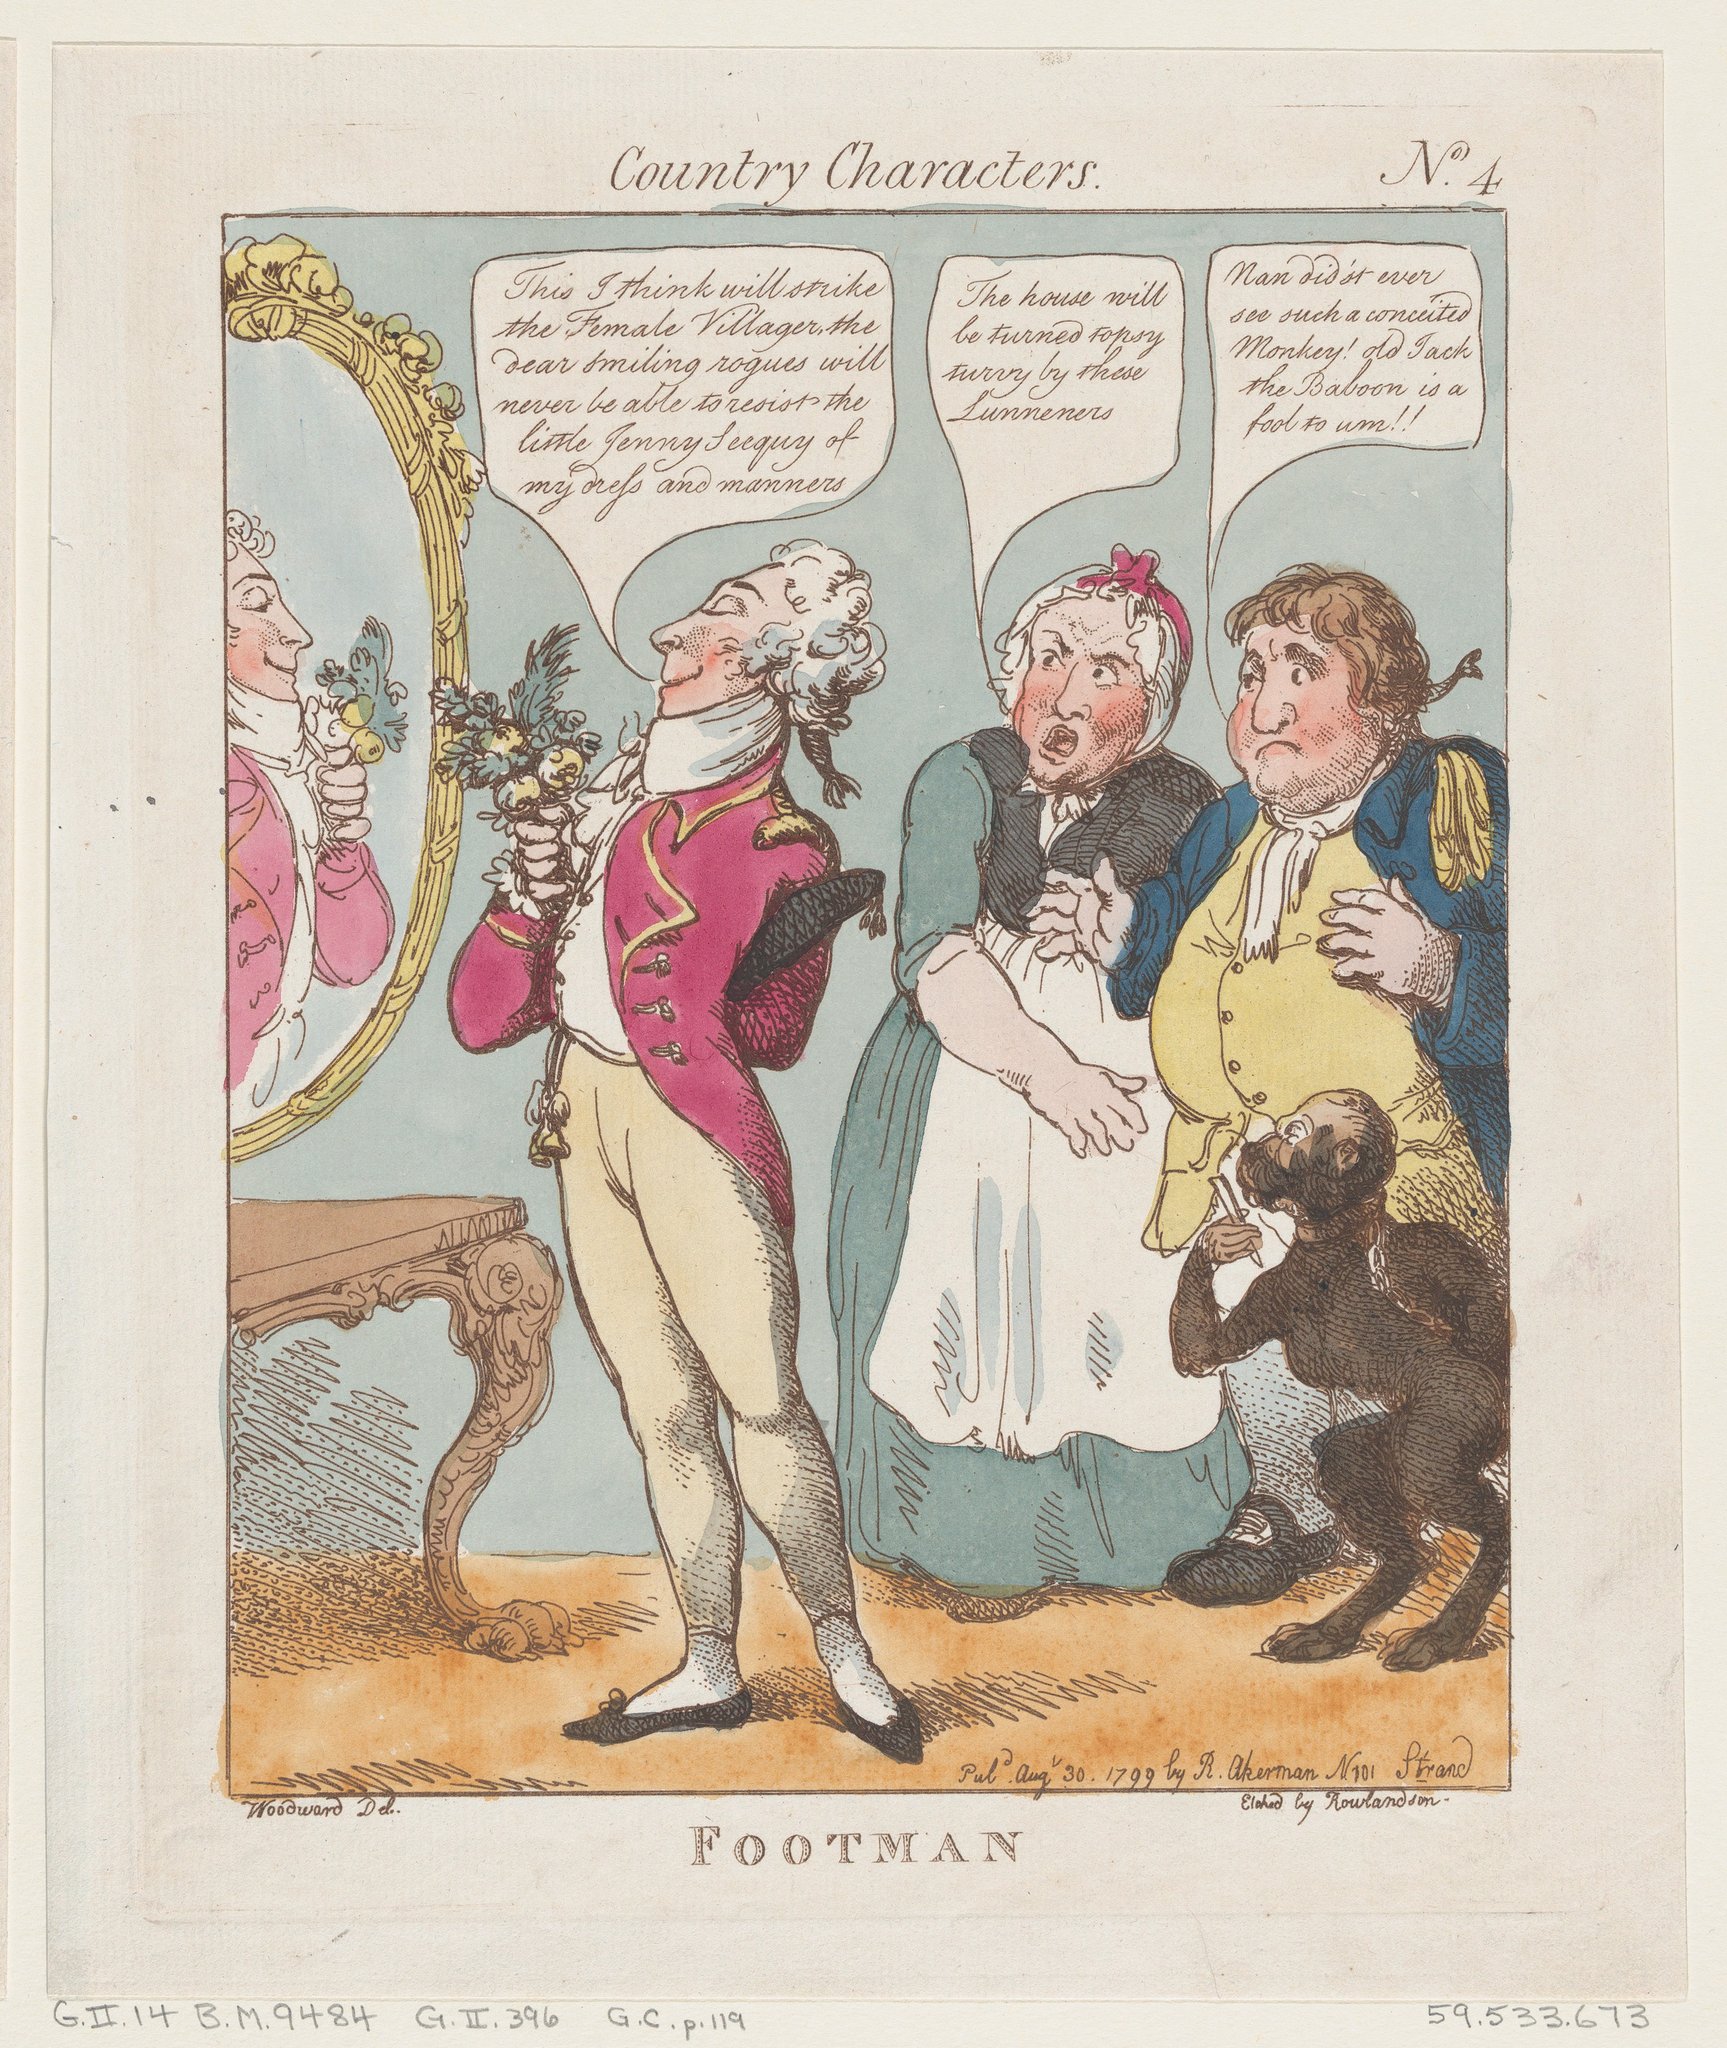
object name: print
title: Footman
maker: thomas rowlandson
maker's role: artist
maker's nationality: british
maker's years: 1757-1827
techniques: etching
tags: satire,men,women,mirrors